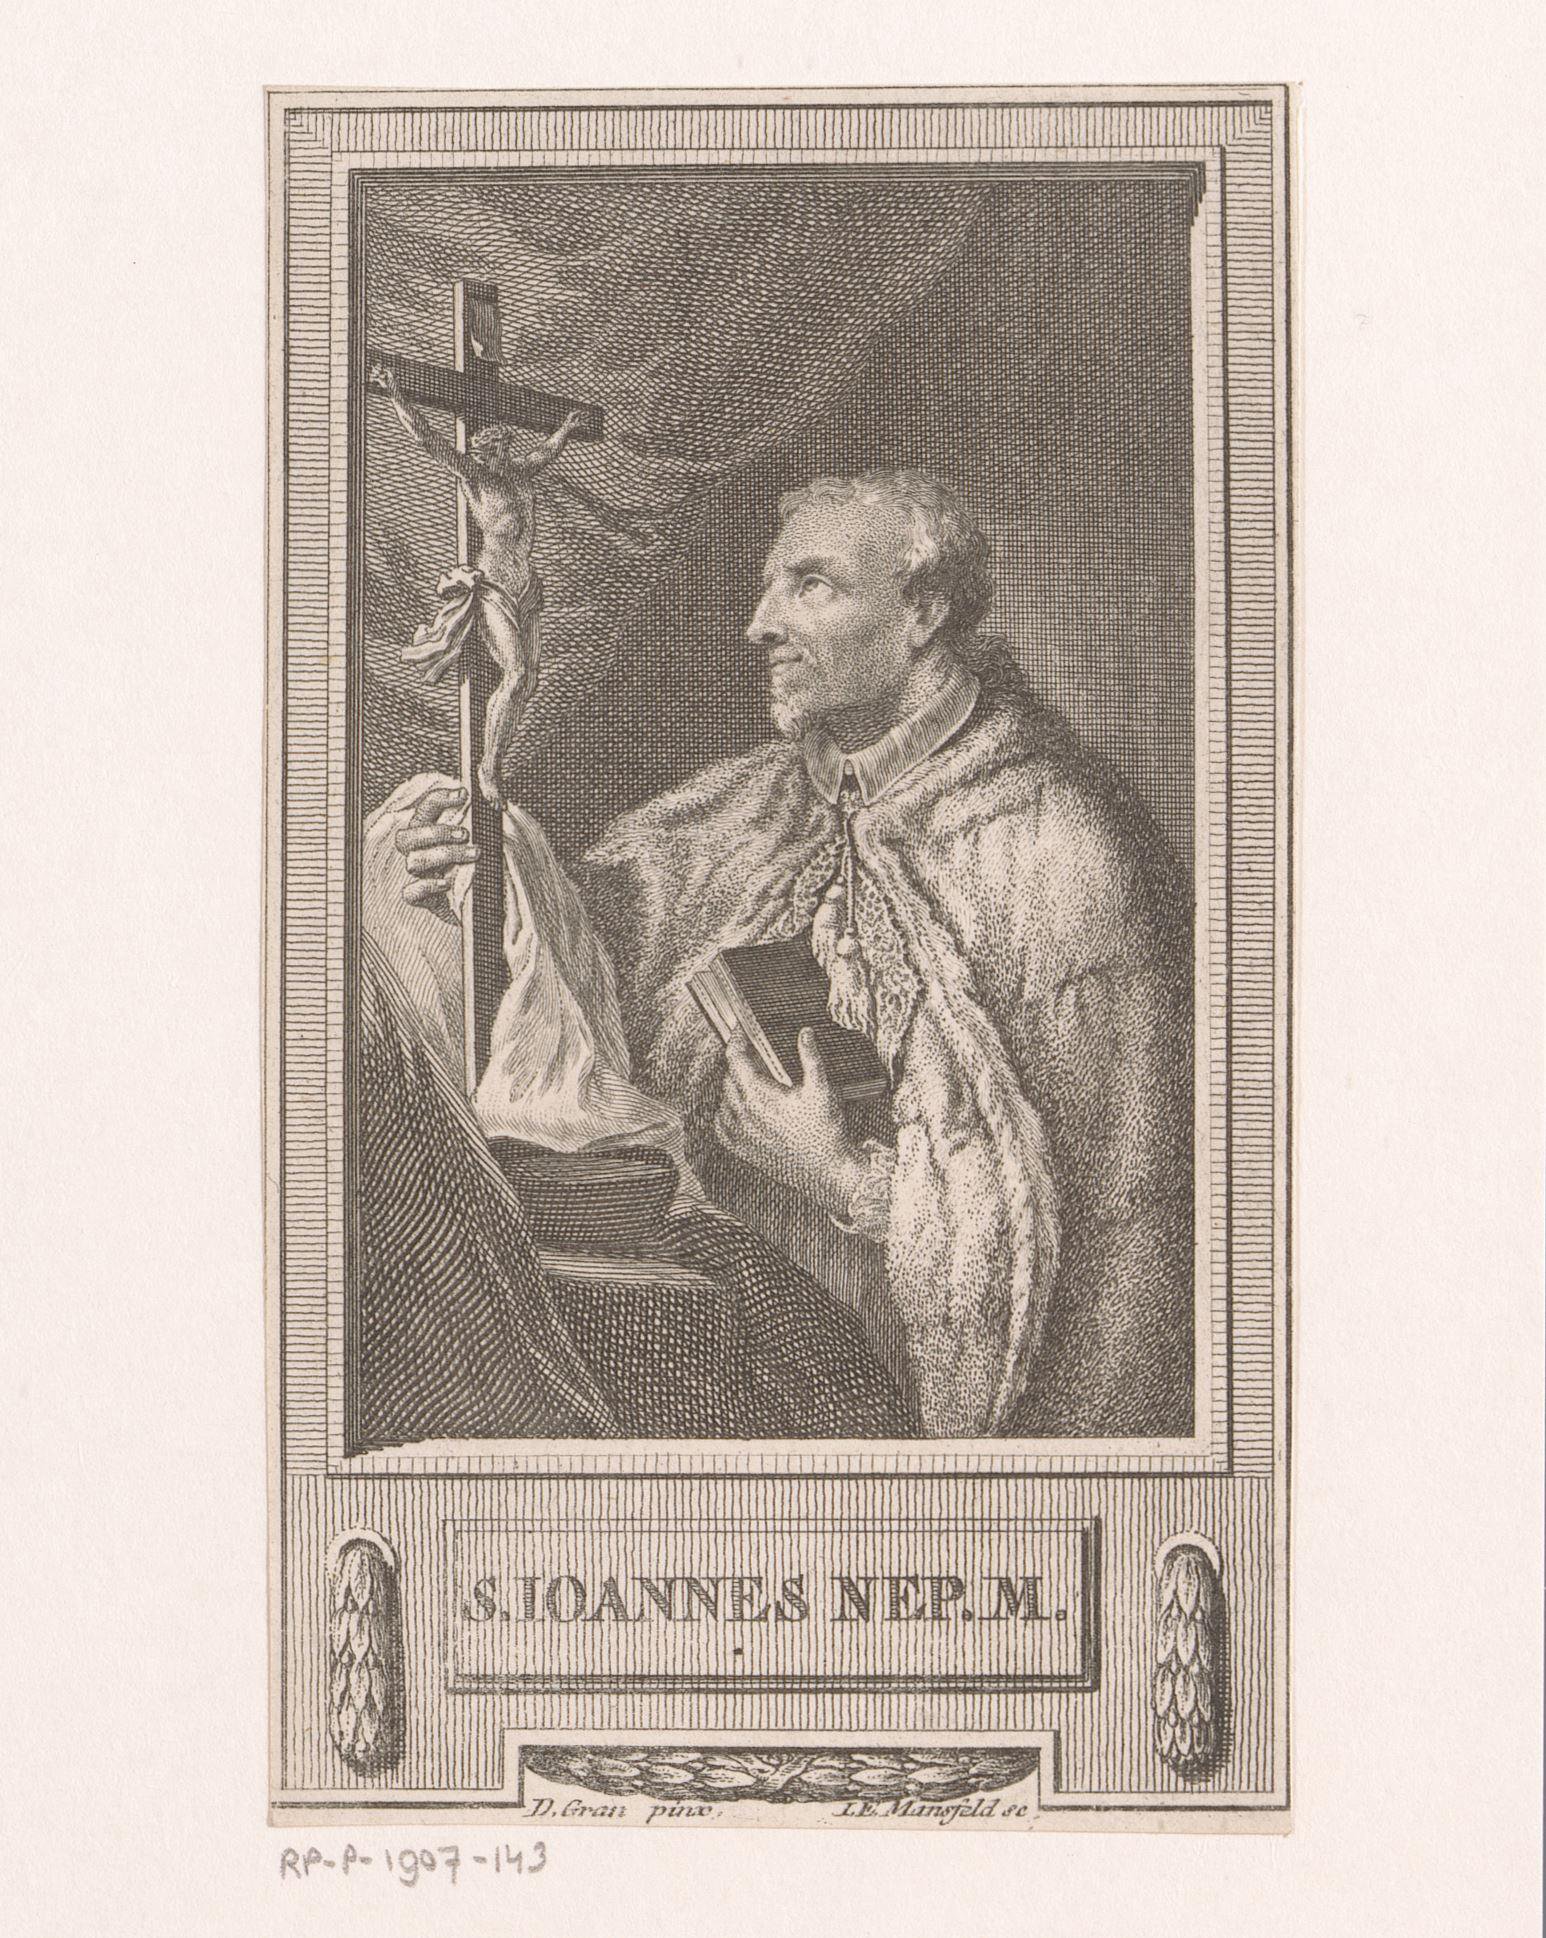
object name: print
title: Heilige Johannes Nepomuk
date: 1749-1796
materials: paper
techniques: engraving, etching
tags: the martyr john nepomuk; possible attributes: book, crucifix, nimbus or crown of five stars, padlock, palm, tongue, saints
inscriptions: collector's mark: Lugt 2228